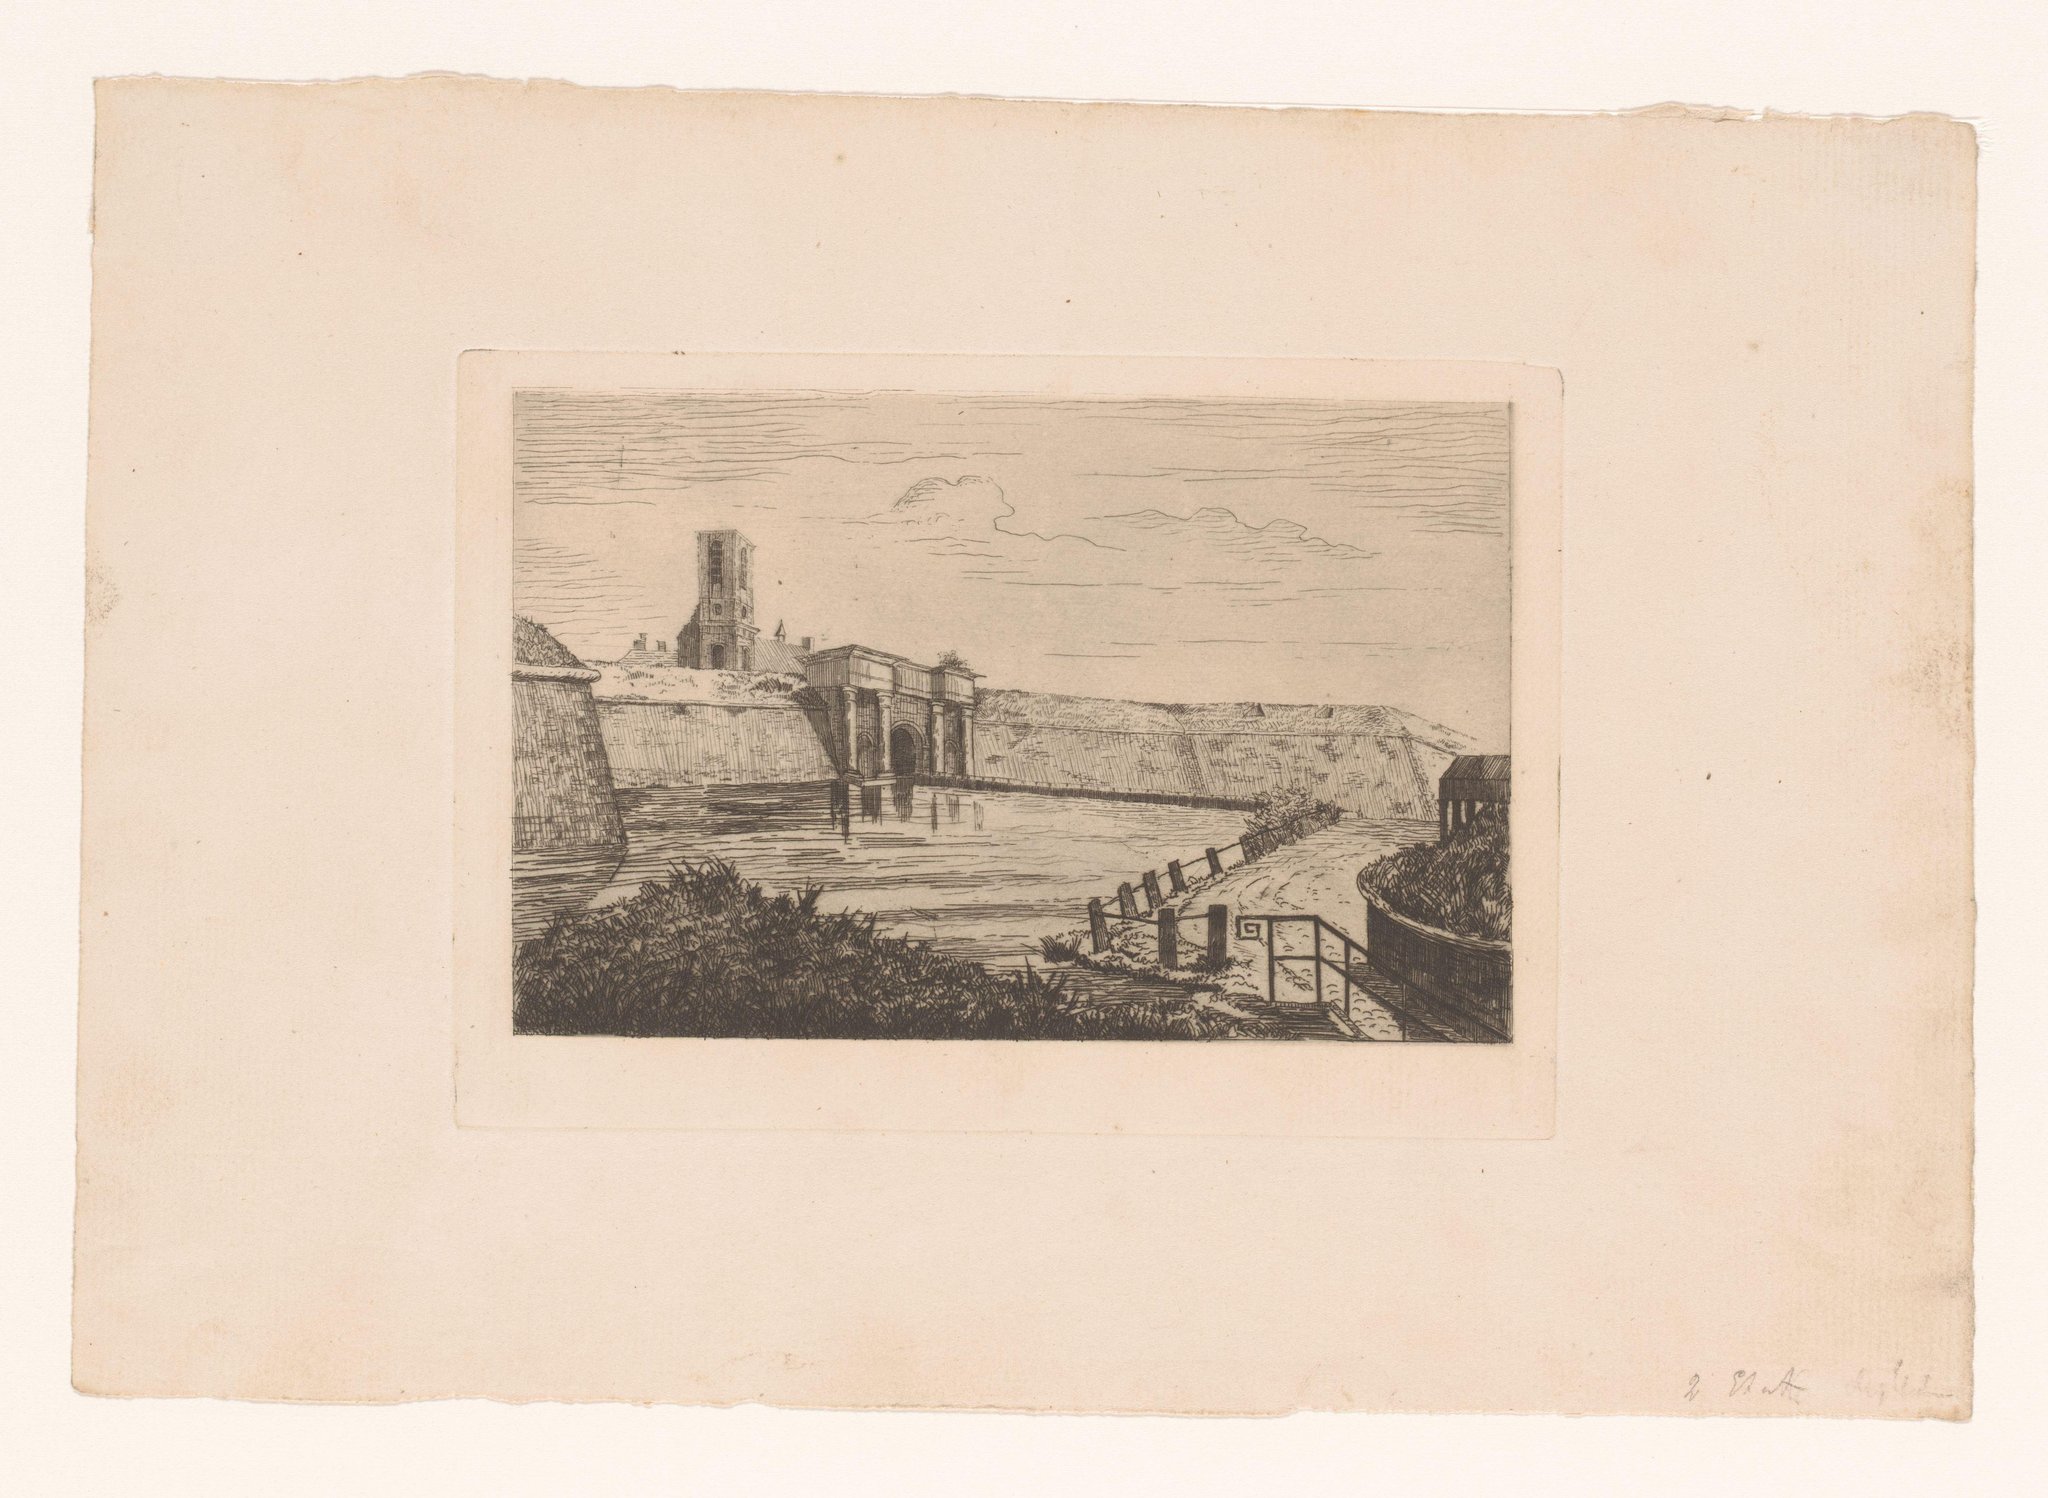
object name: print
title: Gezicht op de ommuurde stad Mons met de Porte du Rivage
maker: léon dolez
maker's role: print maker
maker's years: 1837-1902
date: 1875-1878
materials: paper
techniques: drypoint, etching, intaglio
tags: city-view, and landscape with man-made constructions, village-gate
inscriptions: collector's mark: Lugt 2228